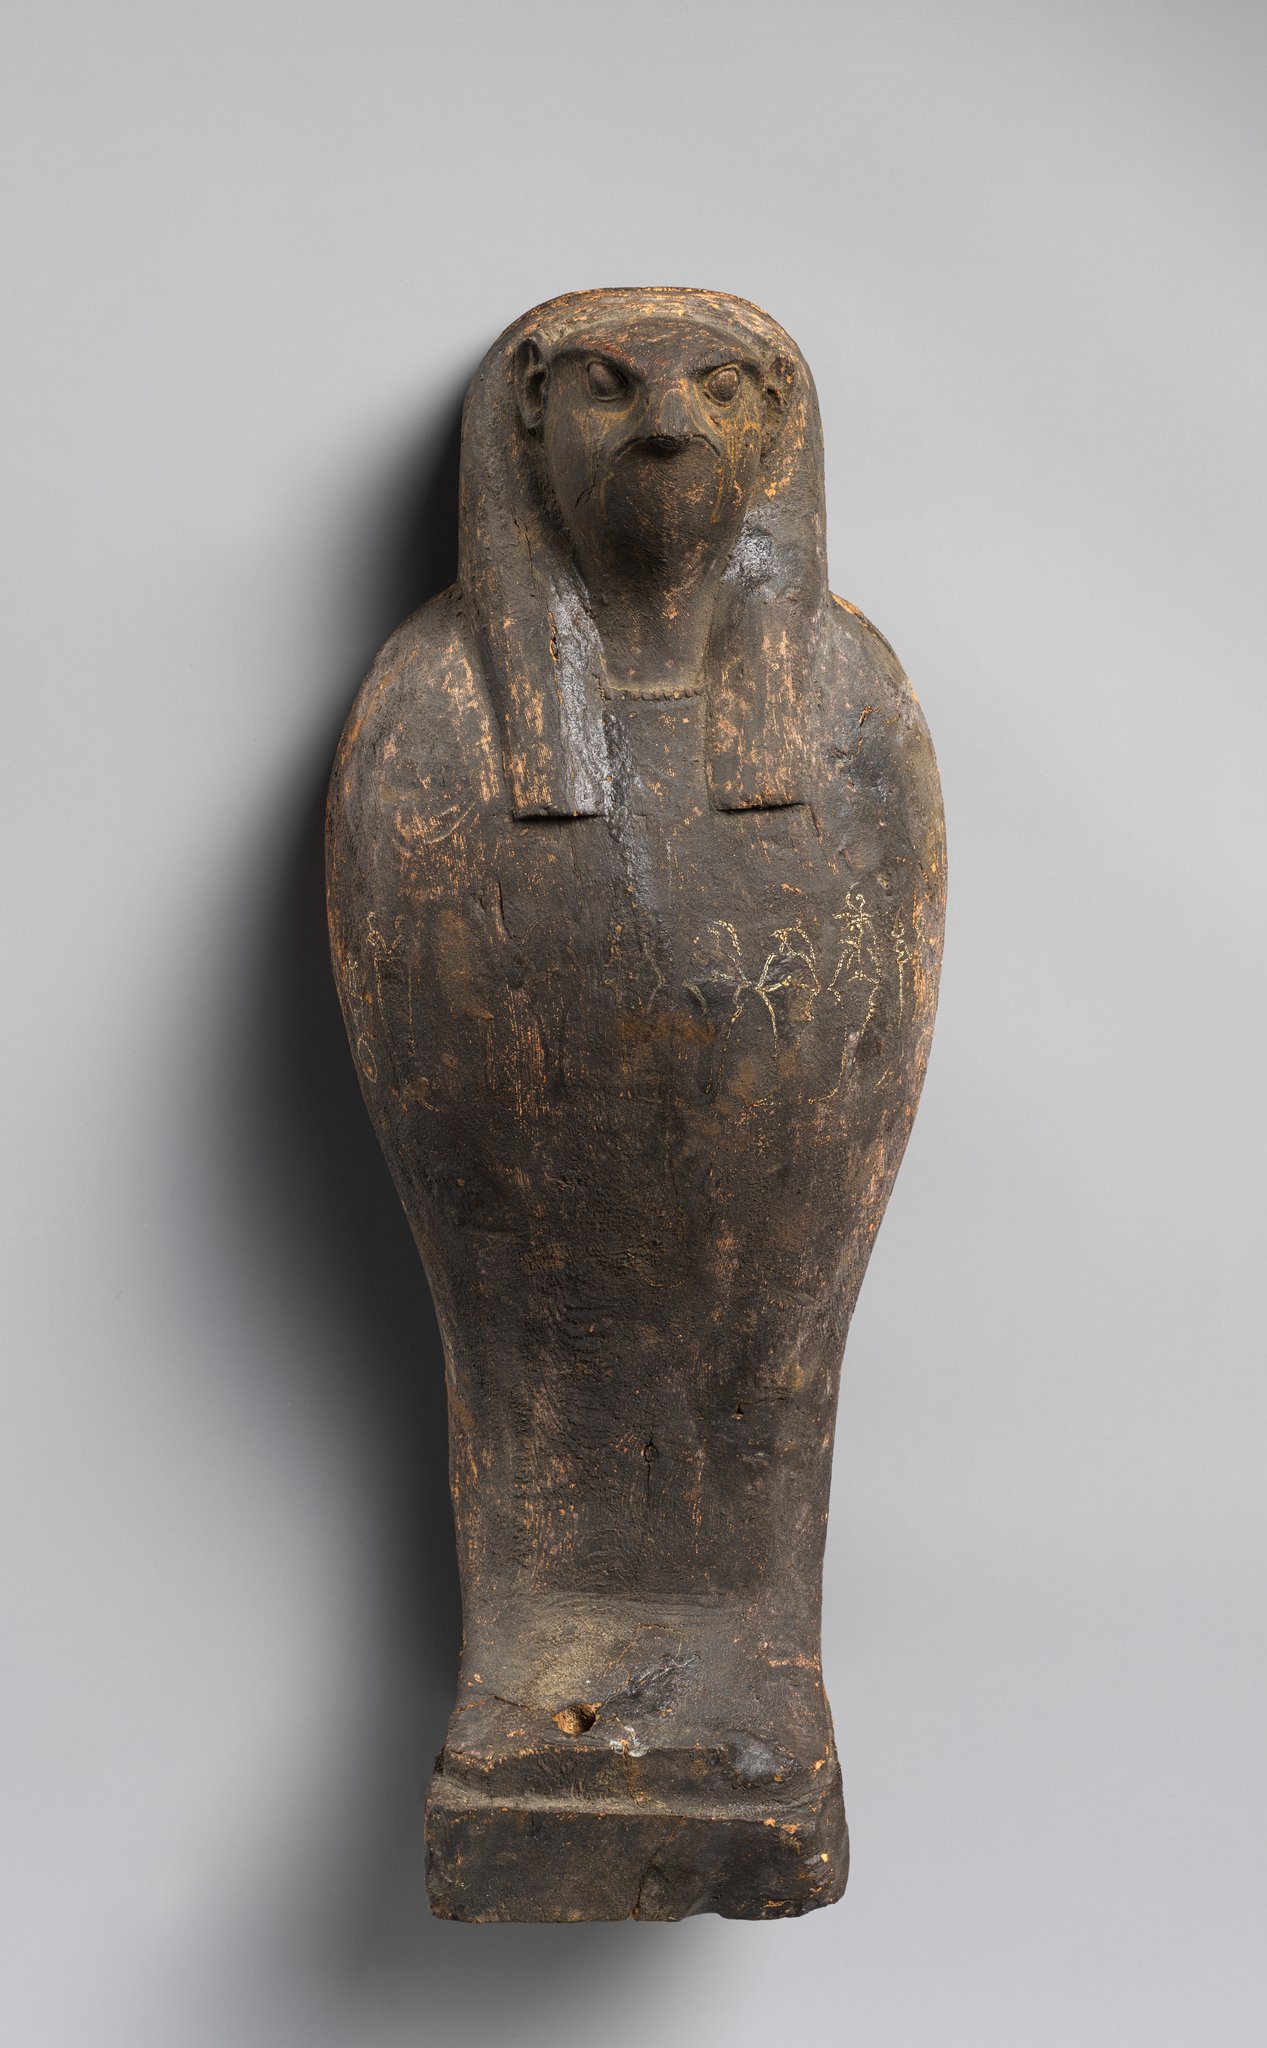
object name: coffin, corn mummy, osiris mask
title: Falcon-headed coffin and grain mummy with Osiris mask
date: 664-630 BCE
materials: linen, paint, wax, wood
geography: egypt